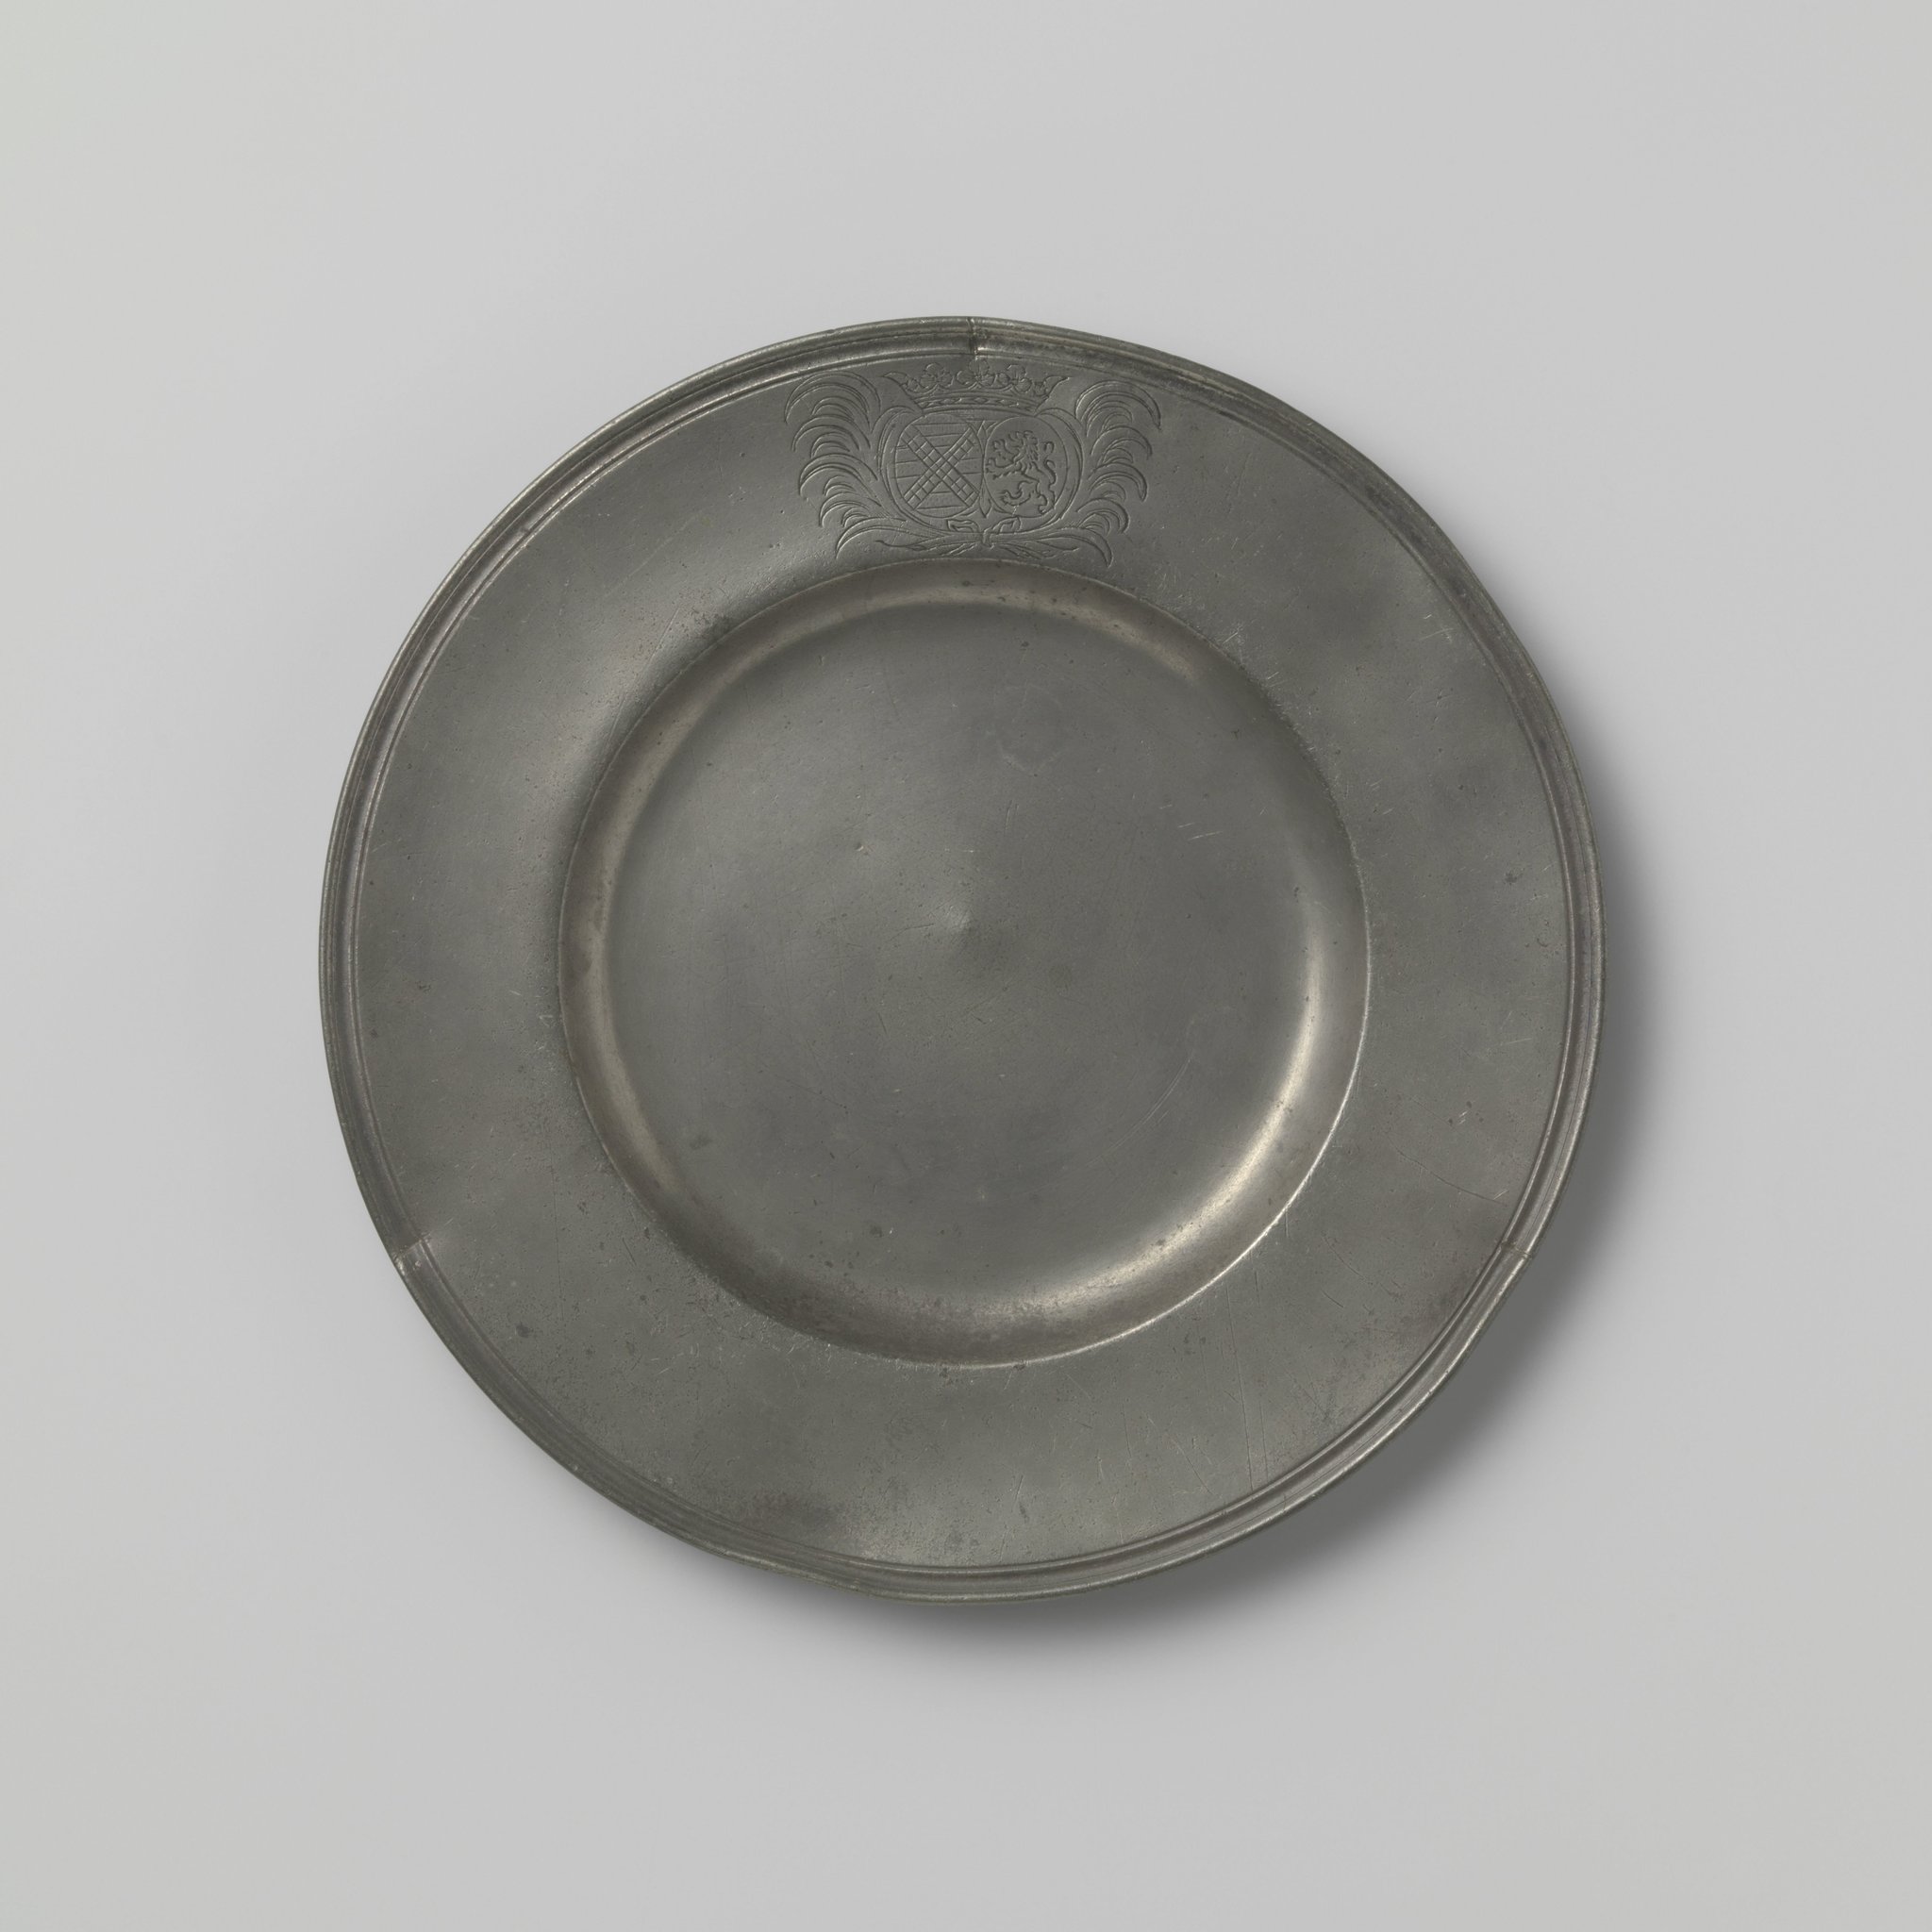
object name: plate dish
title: Bord met het familiewapen Ploos van Amstel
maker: jan gardenier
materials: tin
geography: dordrecht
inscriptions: quality mark, family arms, inscription: ‘KOG’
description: Rond bord van tin met omgevouwen rand. Op de rand het familiewapen Ploos van Amstel.